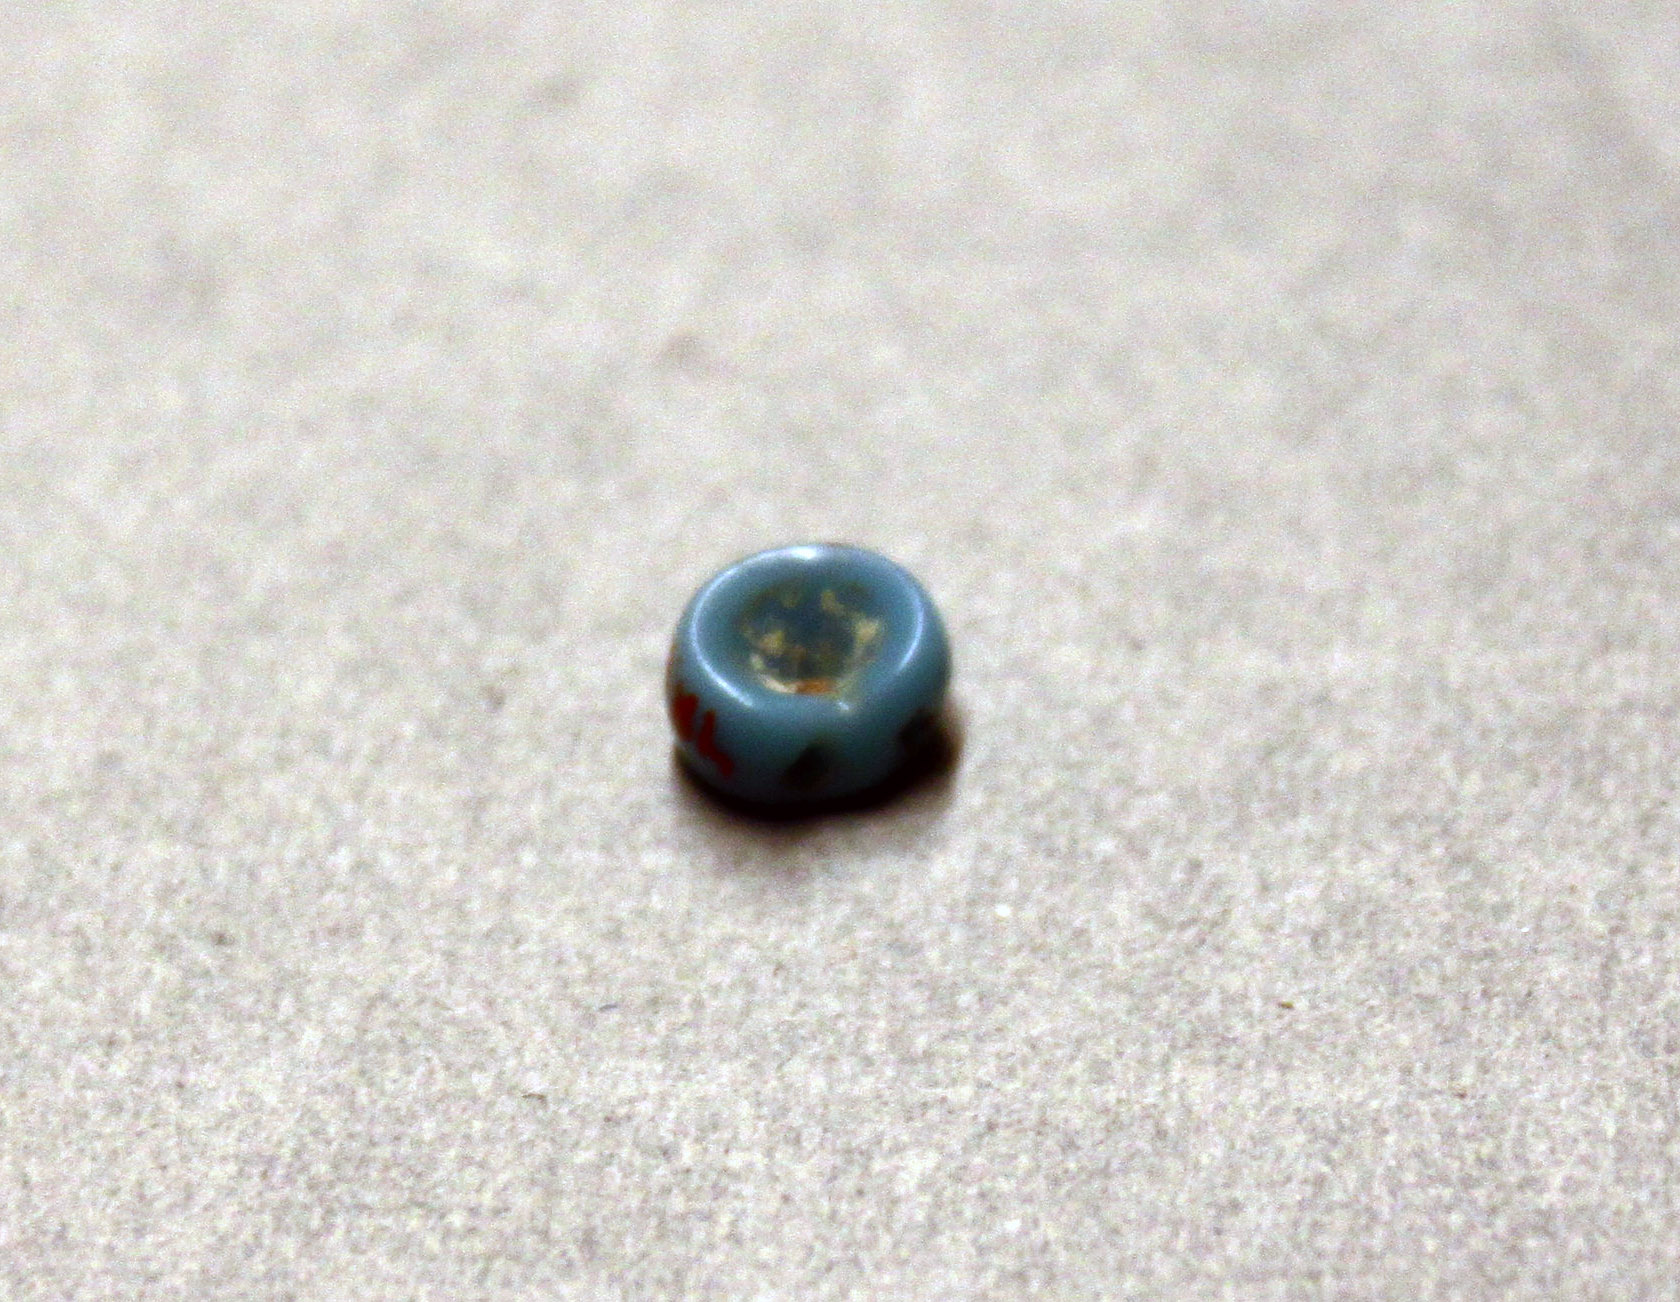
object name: bead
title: Beads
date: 701-1300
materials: glass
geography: iran